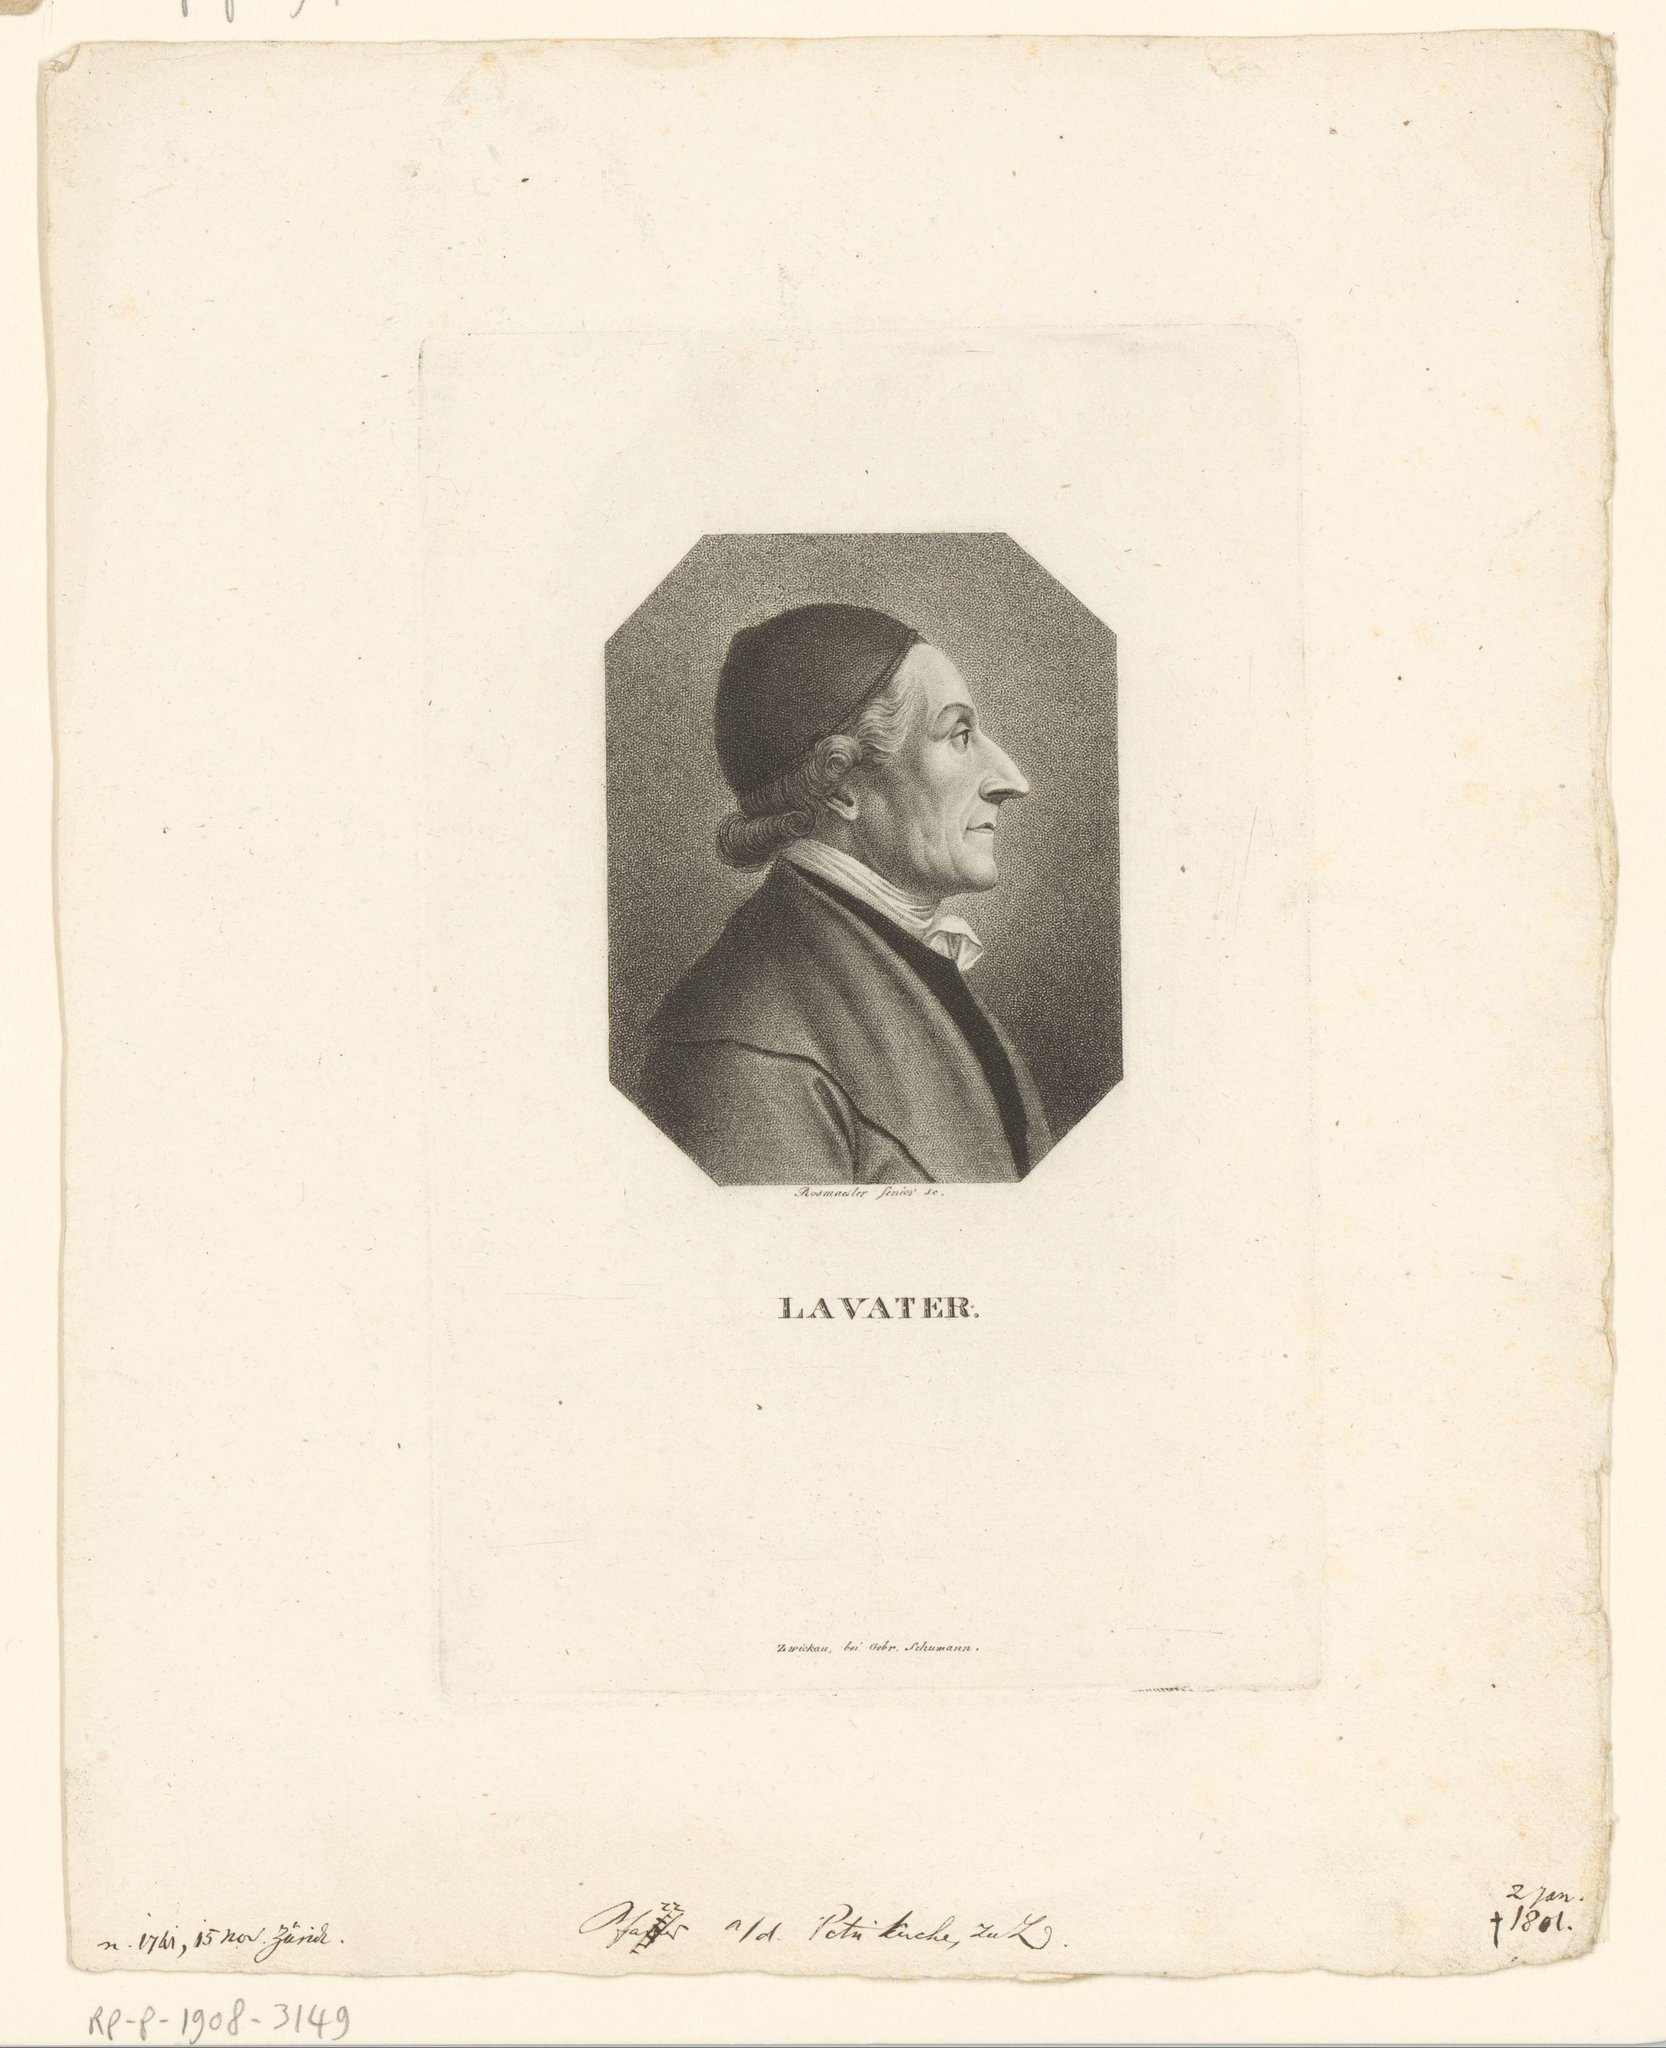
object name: print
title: Portret van Johann Kaspar Lavater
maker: friedrich rossmässler junior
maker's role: artist, print maker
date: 1785-1858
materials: paper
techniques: engraving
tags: johann caspar lavater, historical persons, portrait of a writer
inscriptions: collector's mark: Lugt 2228